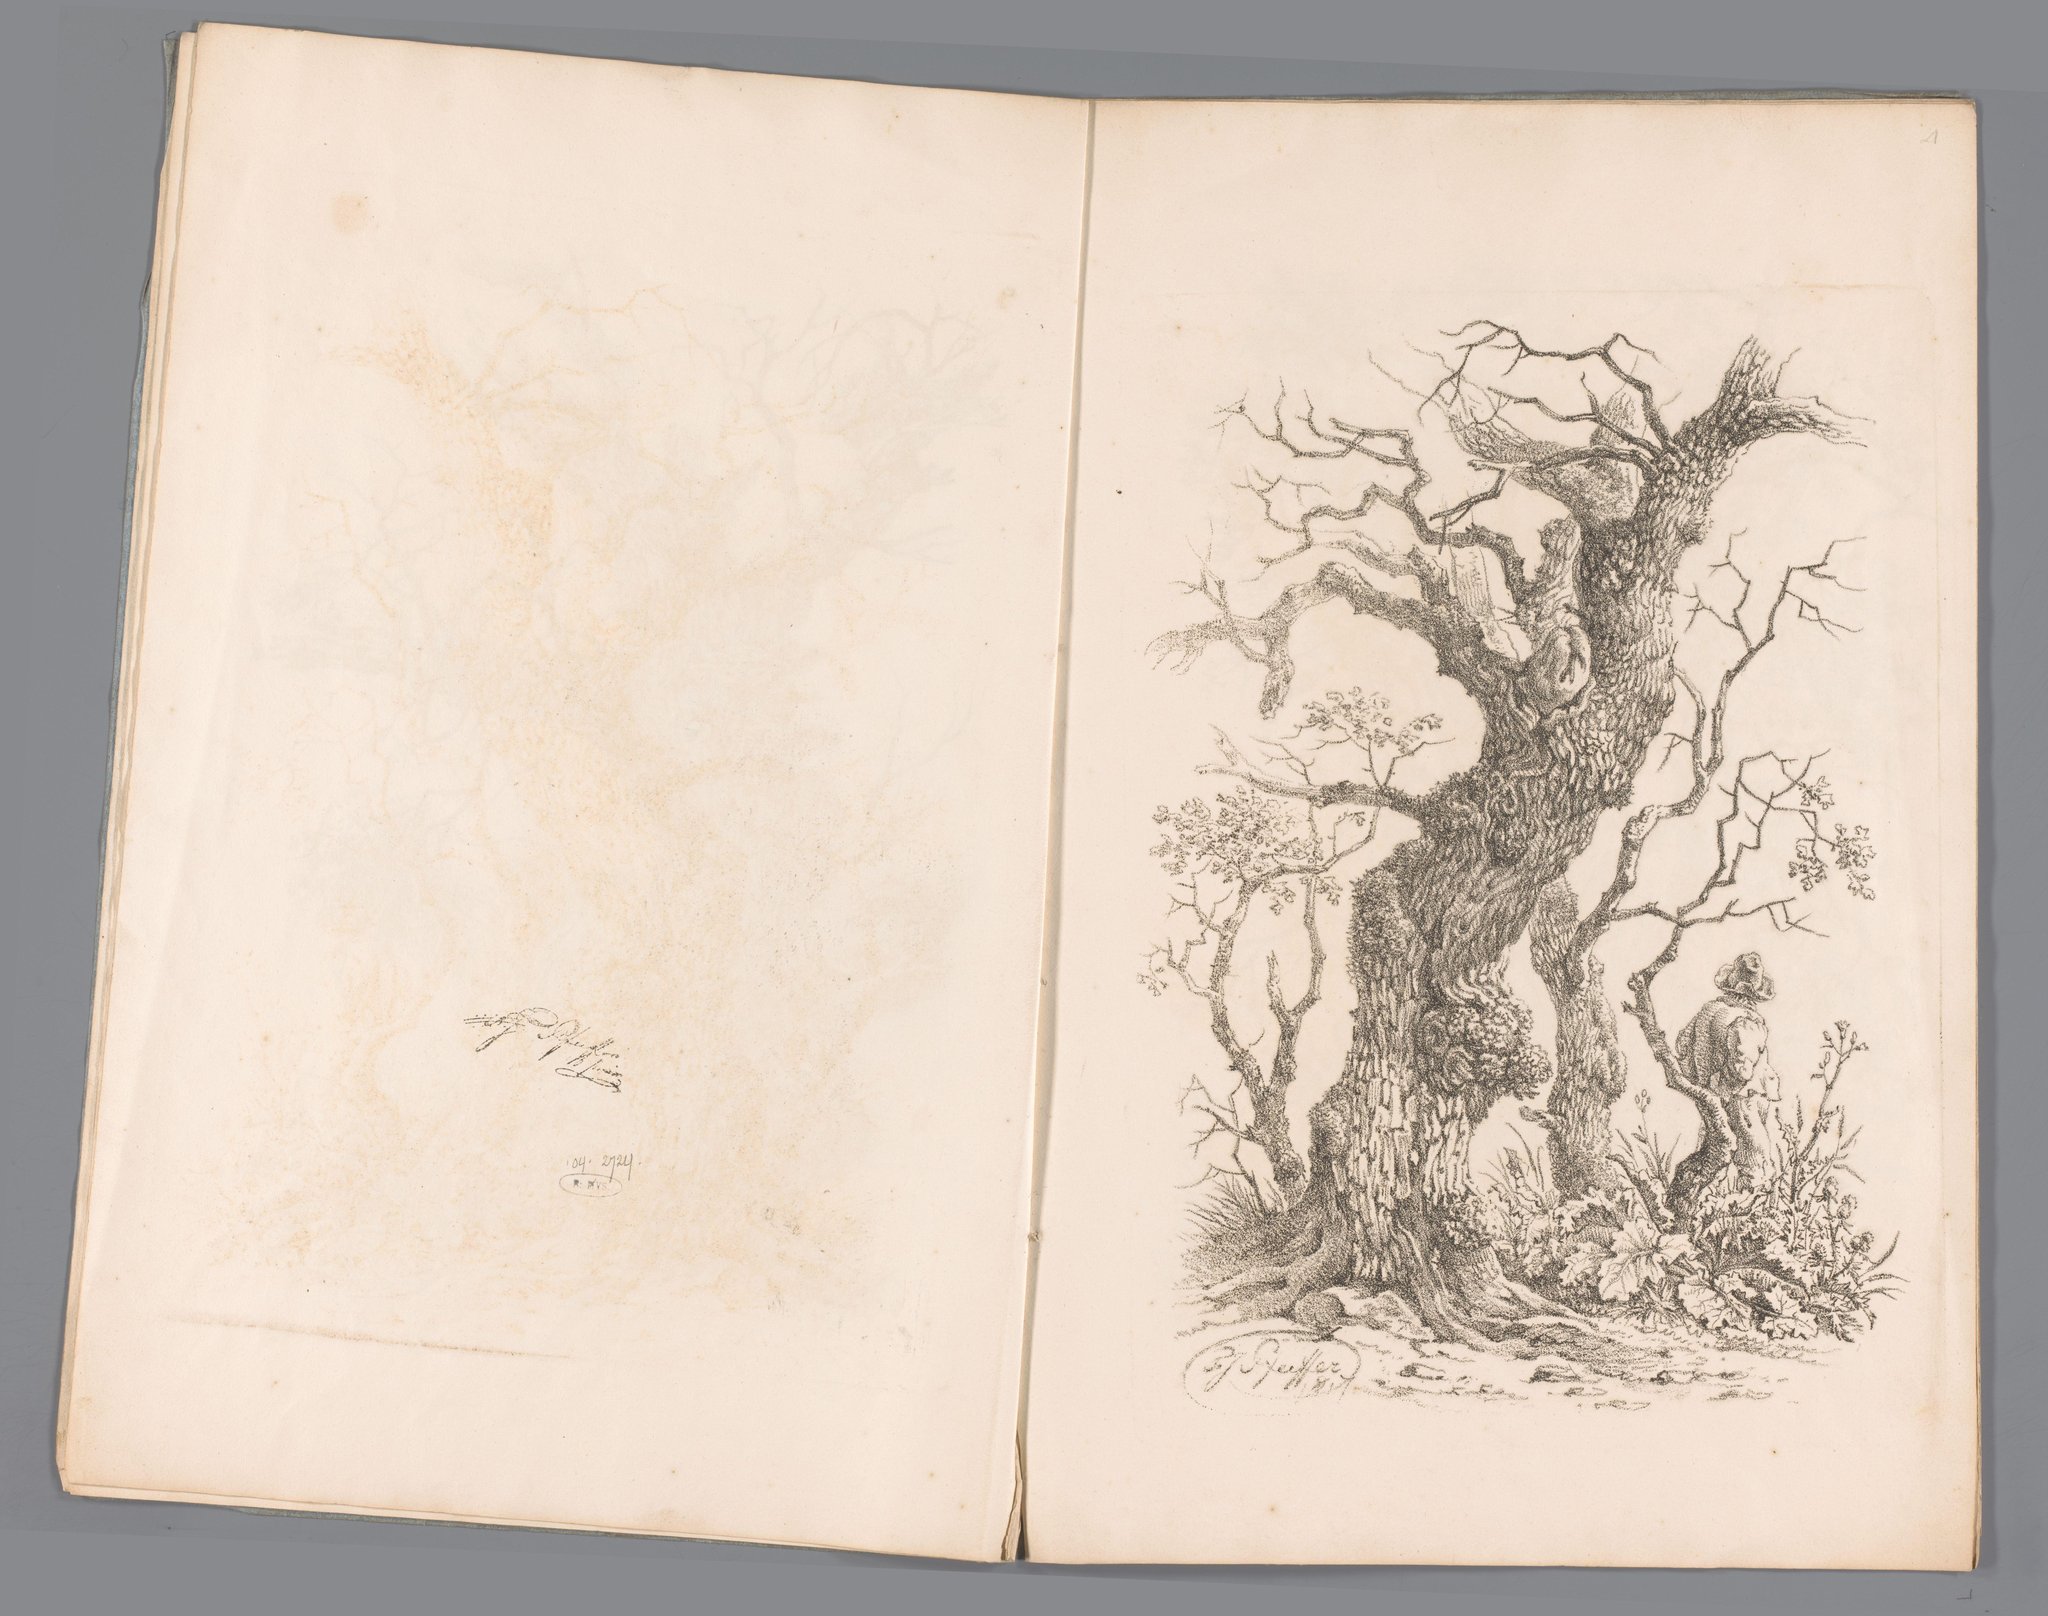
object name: album leaf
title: Etudes du Dessin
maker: françois joseph pfeiffer (ii)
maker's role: draughtsman, print maker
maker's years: 1778-1835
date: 1817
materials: paper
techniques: lithograph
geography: amsterdam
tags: forest, wood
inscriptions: signature: ‘F.P. Pfeiffer junior’, collector's mark: Lugt 2228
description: Rechts naast een boom staat een man op de rug gezien met de handen op de rug. Maakt deel uit van een prentalbum met een serie van zes boomstudies.